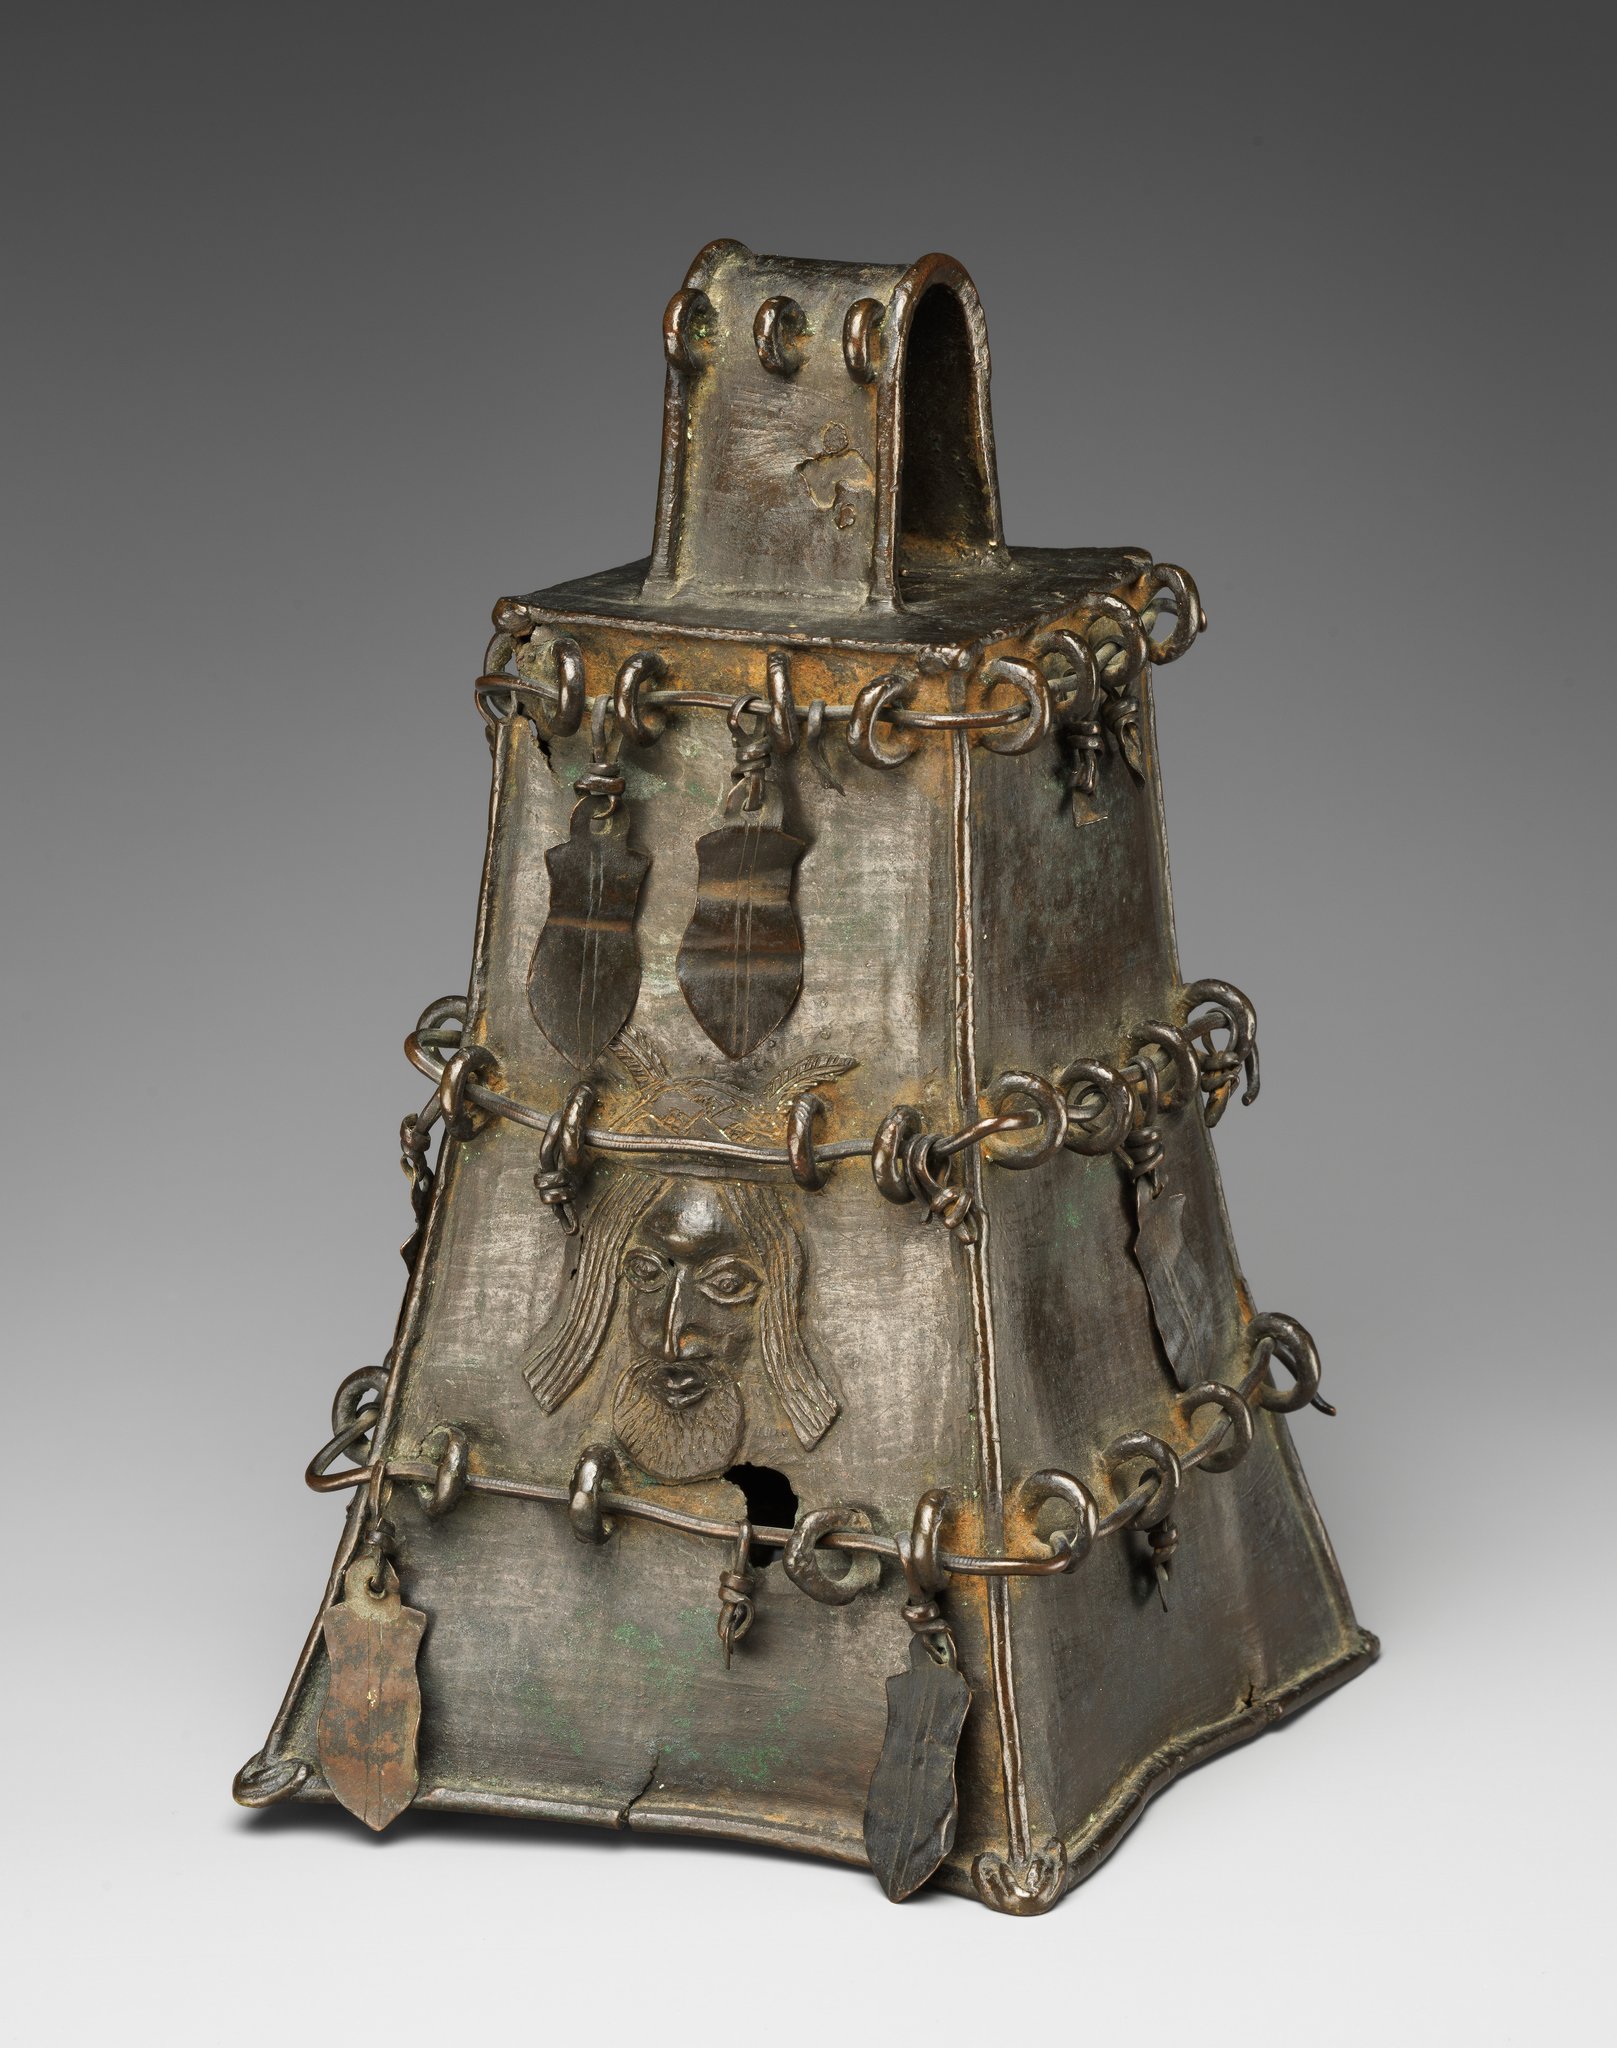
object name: bell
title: Altar bell with Portuguese heads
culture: edo period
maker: ìgùn ẹ́rọ̀nwwọ̀n (brass-casting guild) artists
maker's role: artist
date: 1501-1700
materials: brass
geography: nigeria